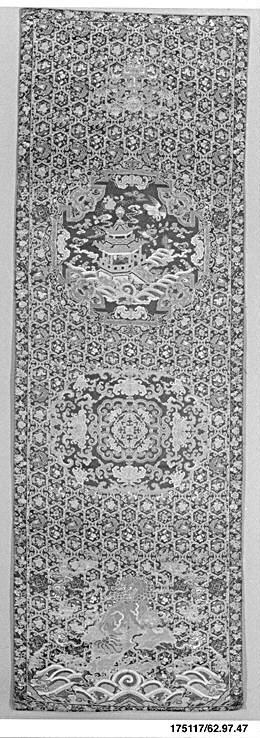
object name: chair strip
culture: chinese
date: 1701-1733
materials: metal thread, silk